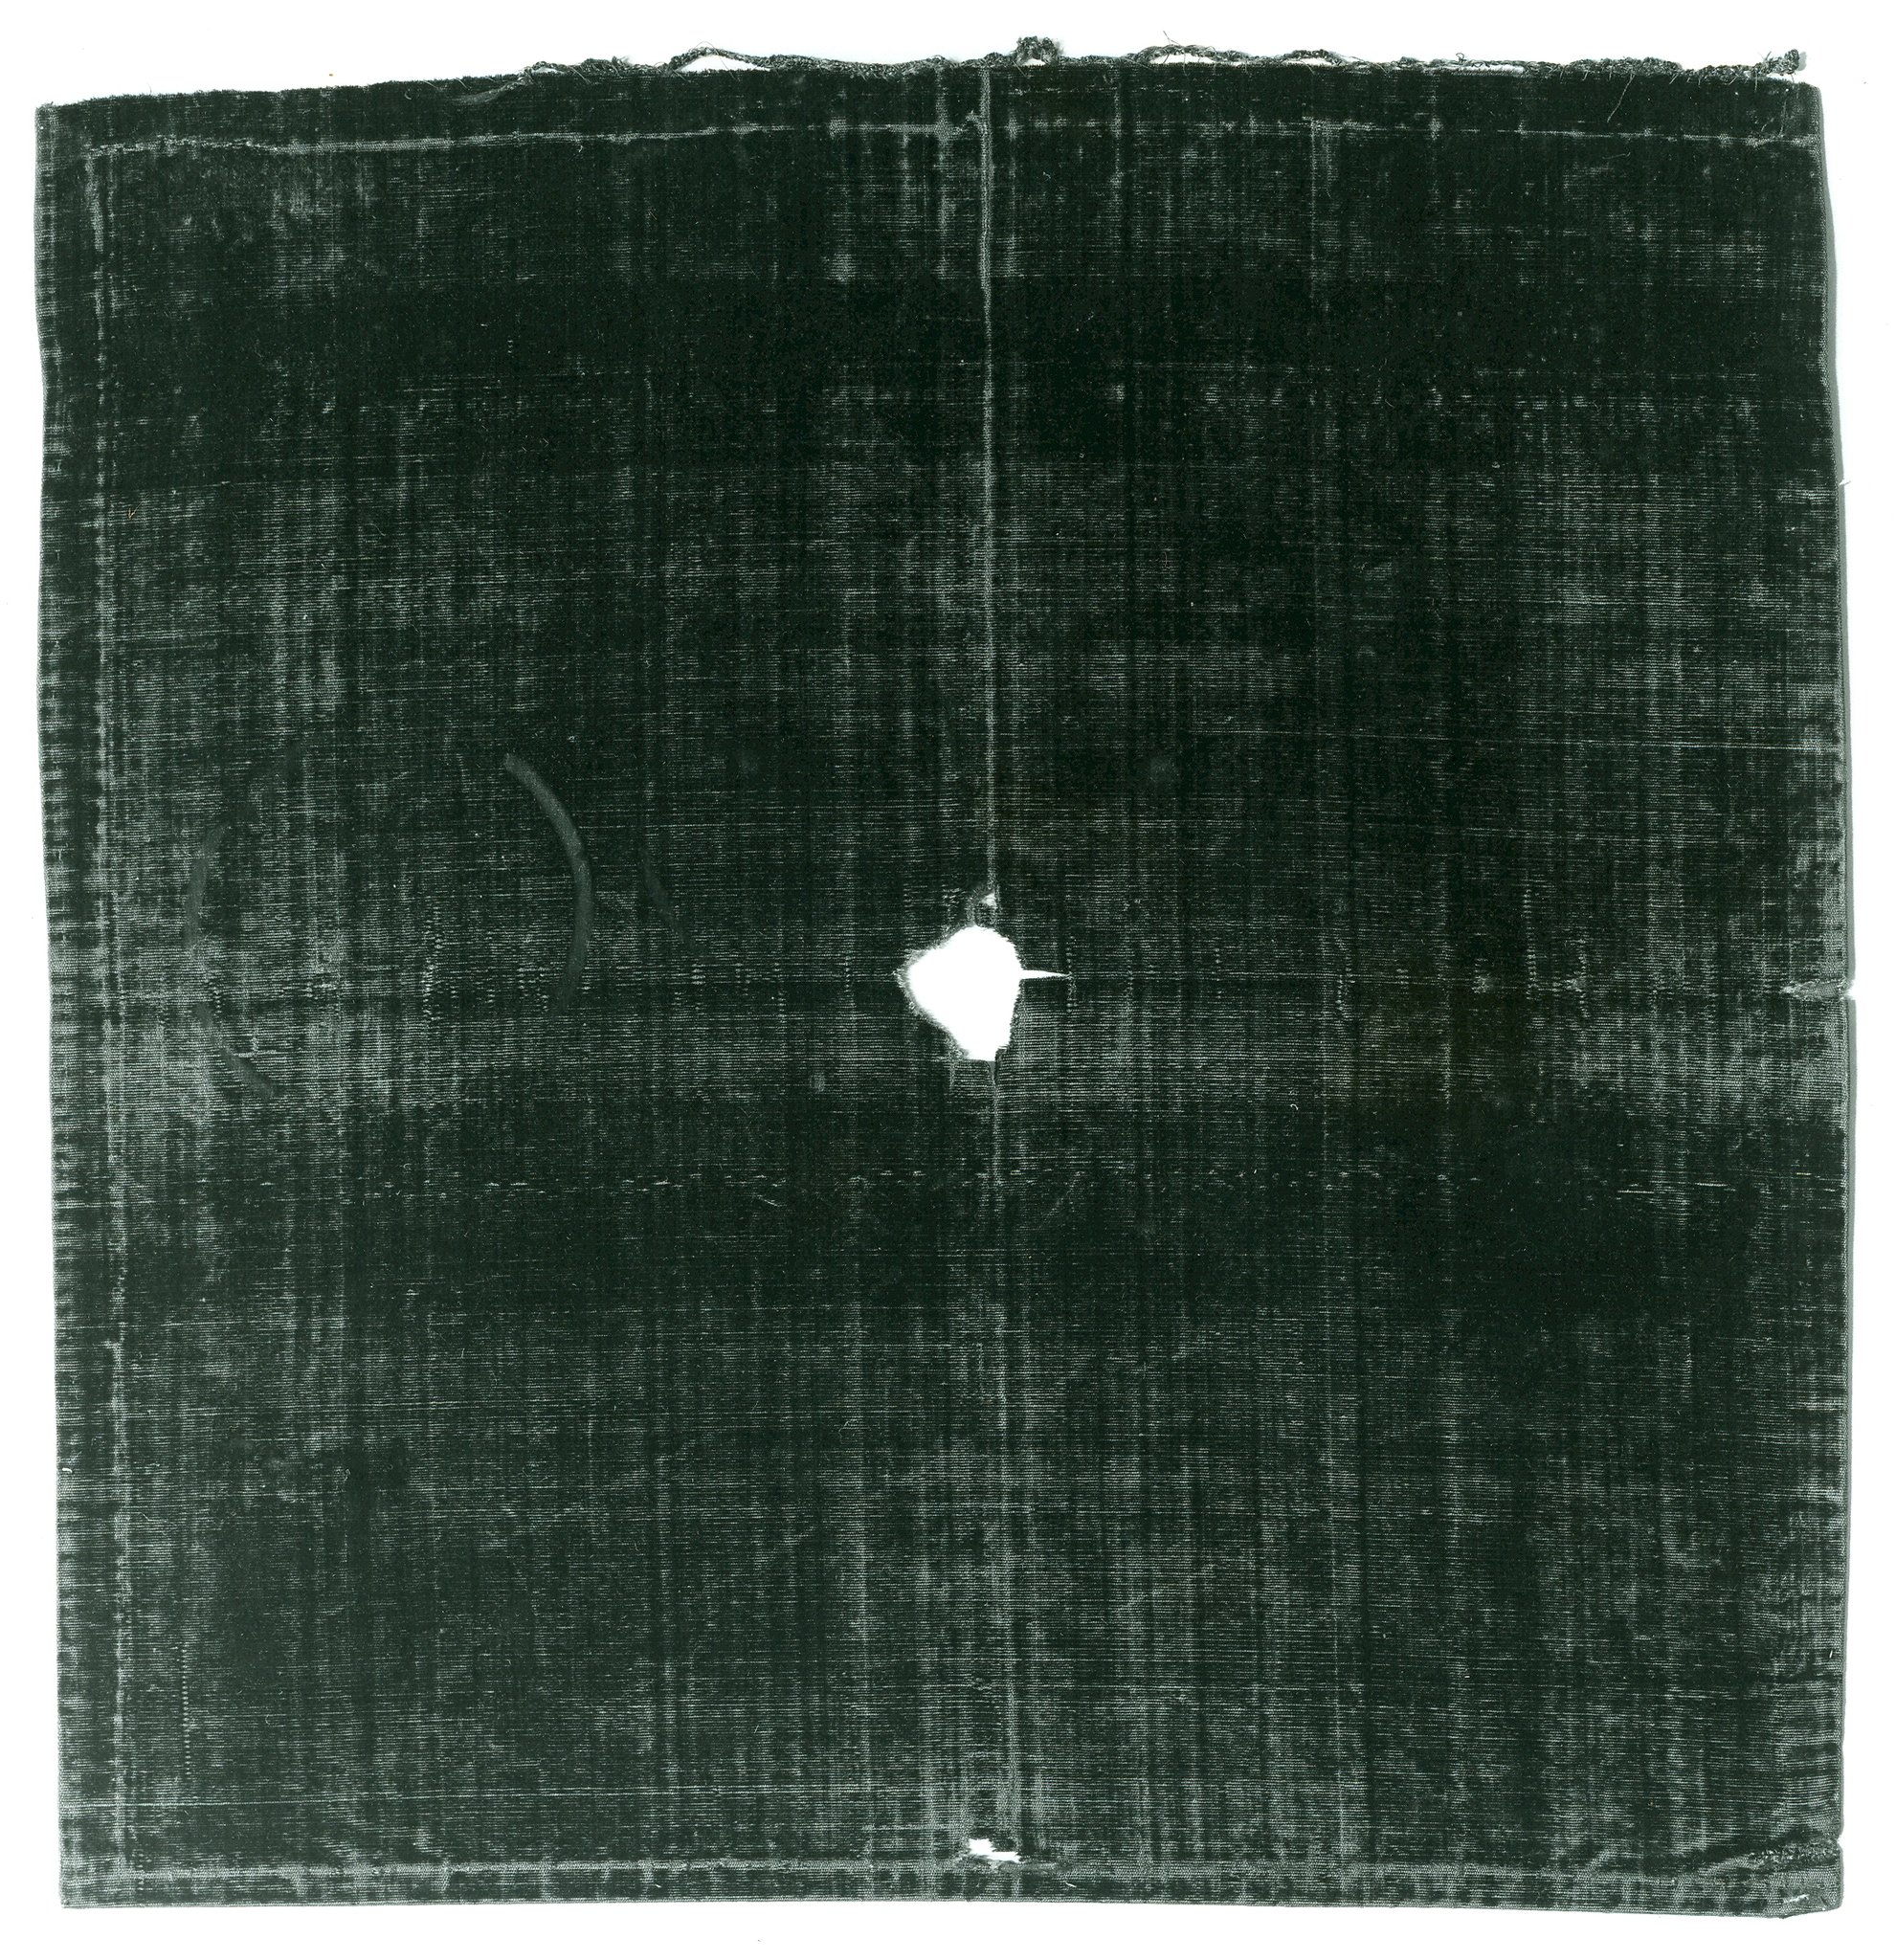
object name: textile cover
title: Cover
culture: italian or spanish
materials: silk